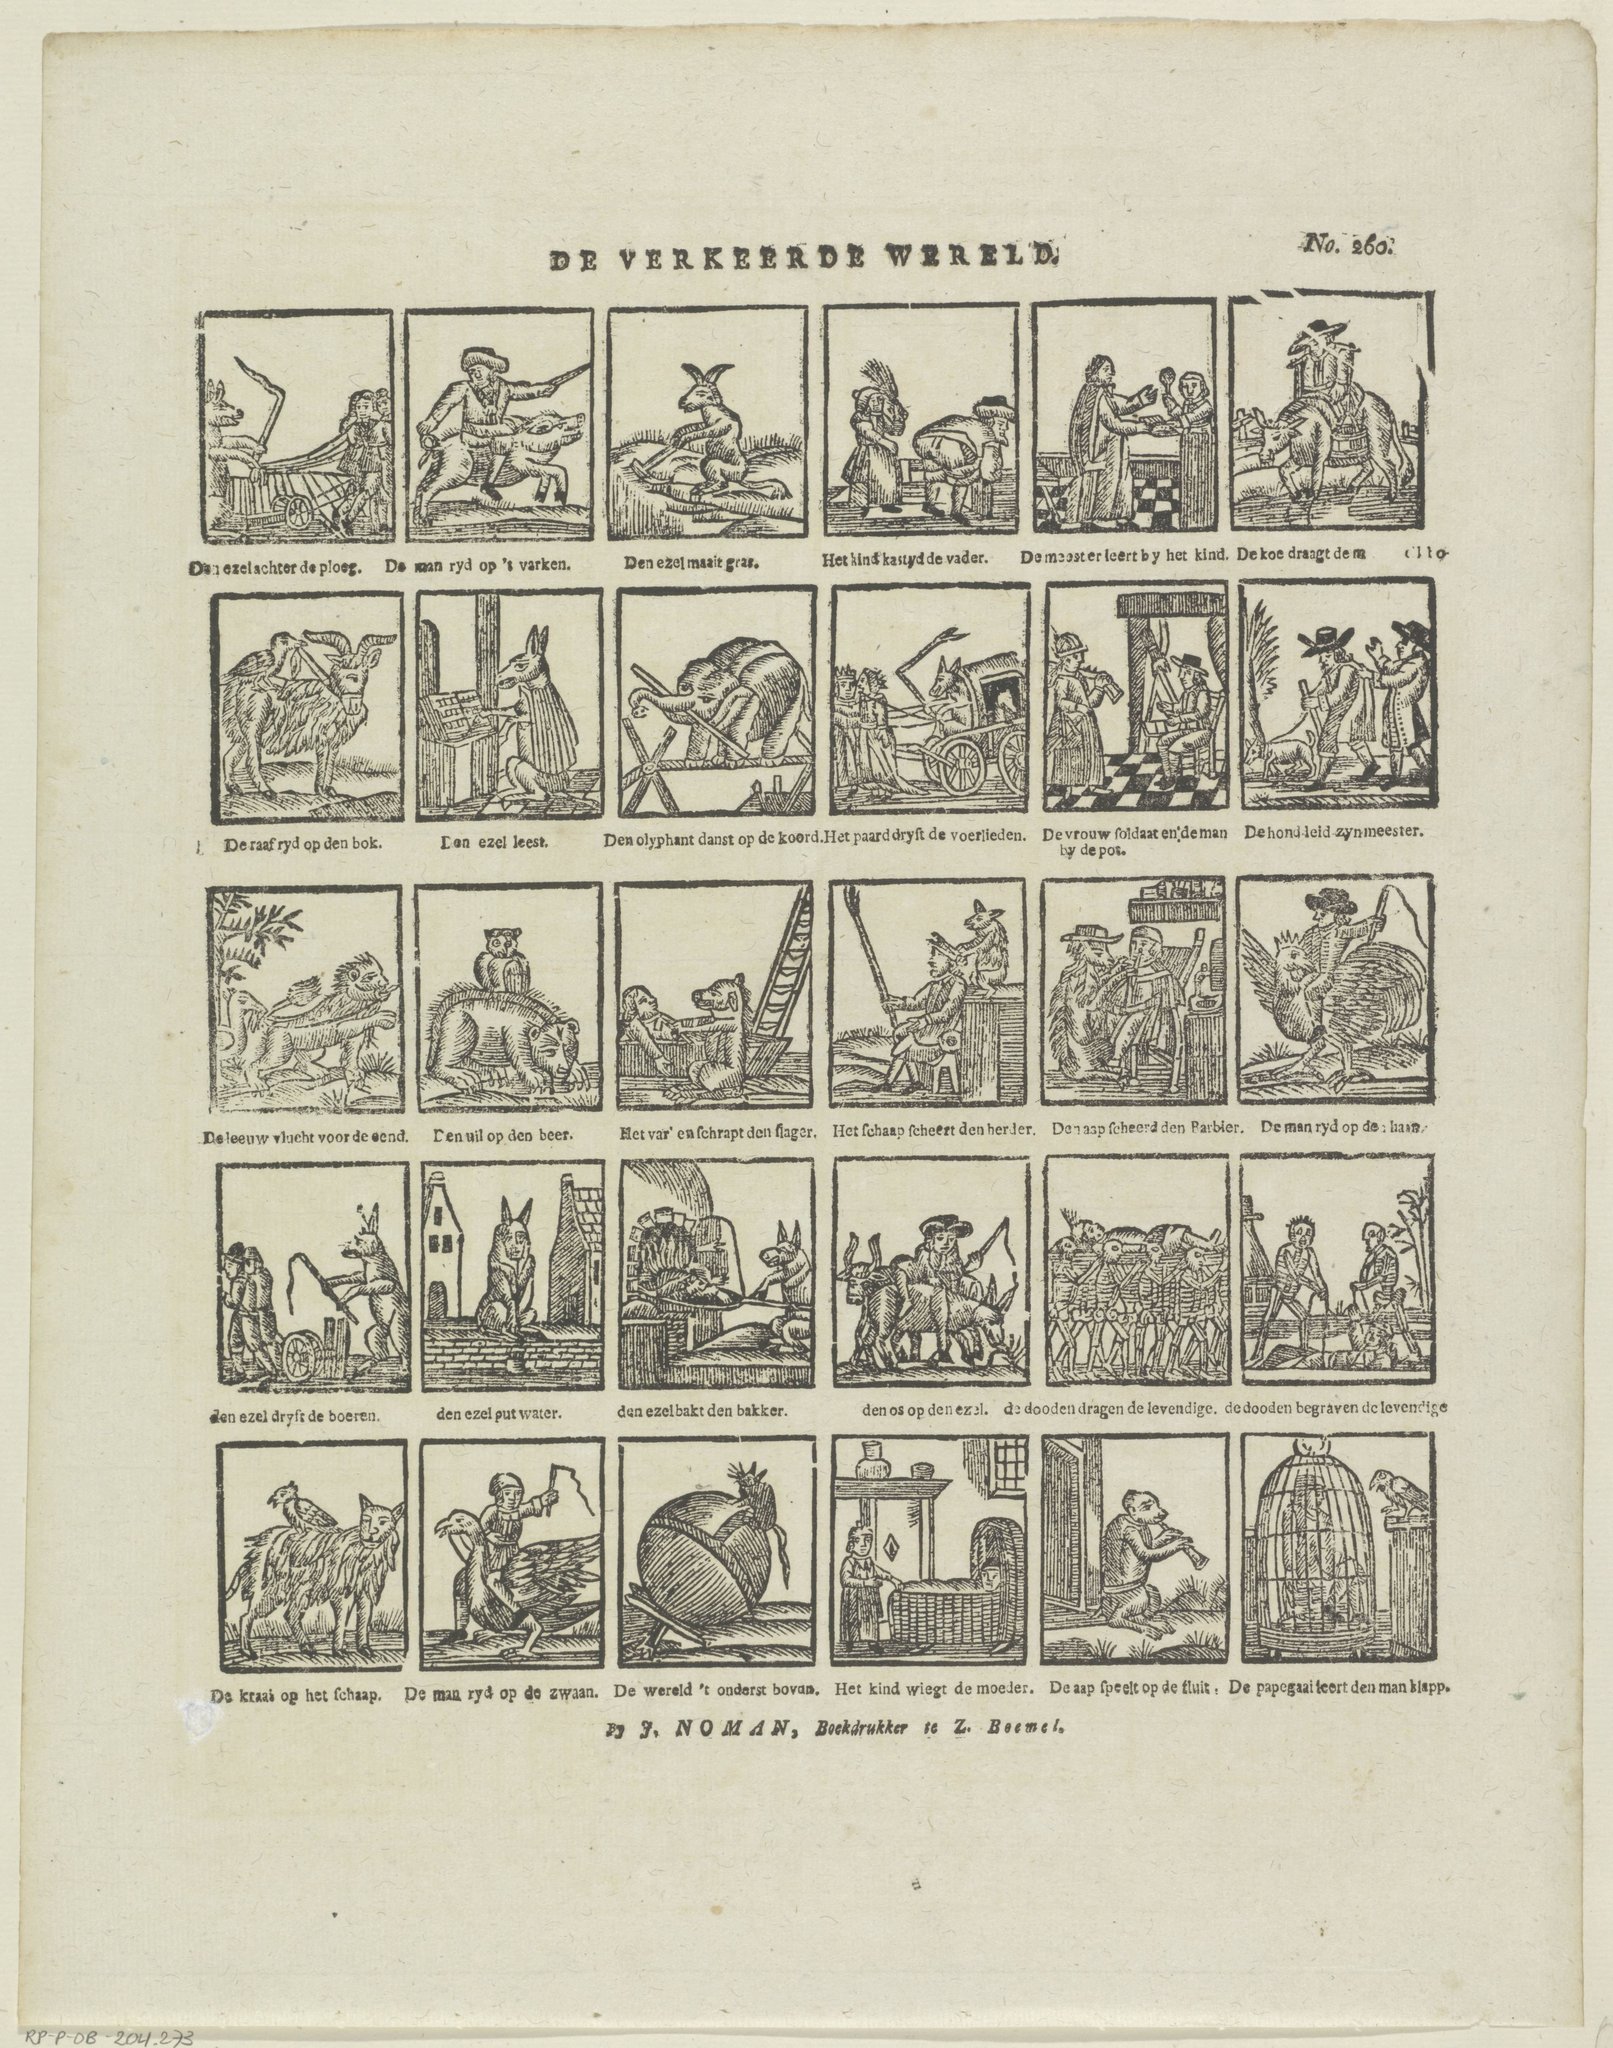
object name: popular print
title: De verkeerde wereld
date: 1806-1830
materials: paper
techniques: letterpress printing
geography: zaltbommel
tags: 'mundus inversus', the reversed world, the topsy-turvy world, 'le monde bestourné', animals acting as human beings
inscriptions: collector's mark: Lugt 2760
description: Blad met 30 voorstellingen over de verkeerde wereld, waar onder andere dieren zich als mensen gedragen. Onder elke afbeelding een onderschrift. Genummerd rechtsboven: No. 260.